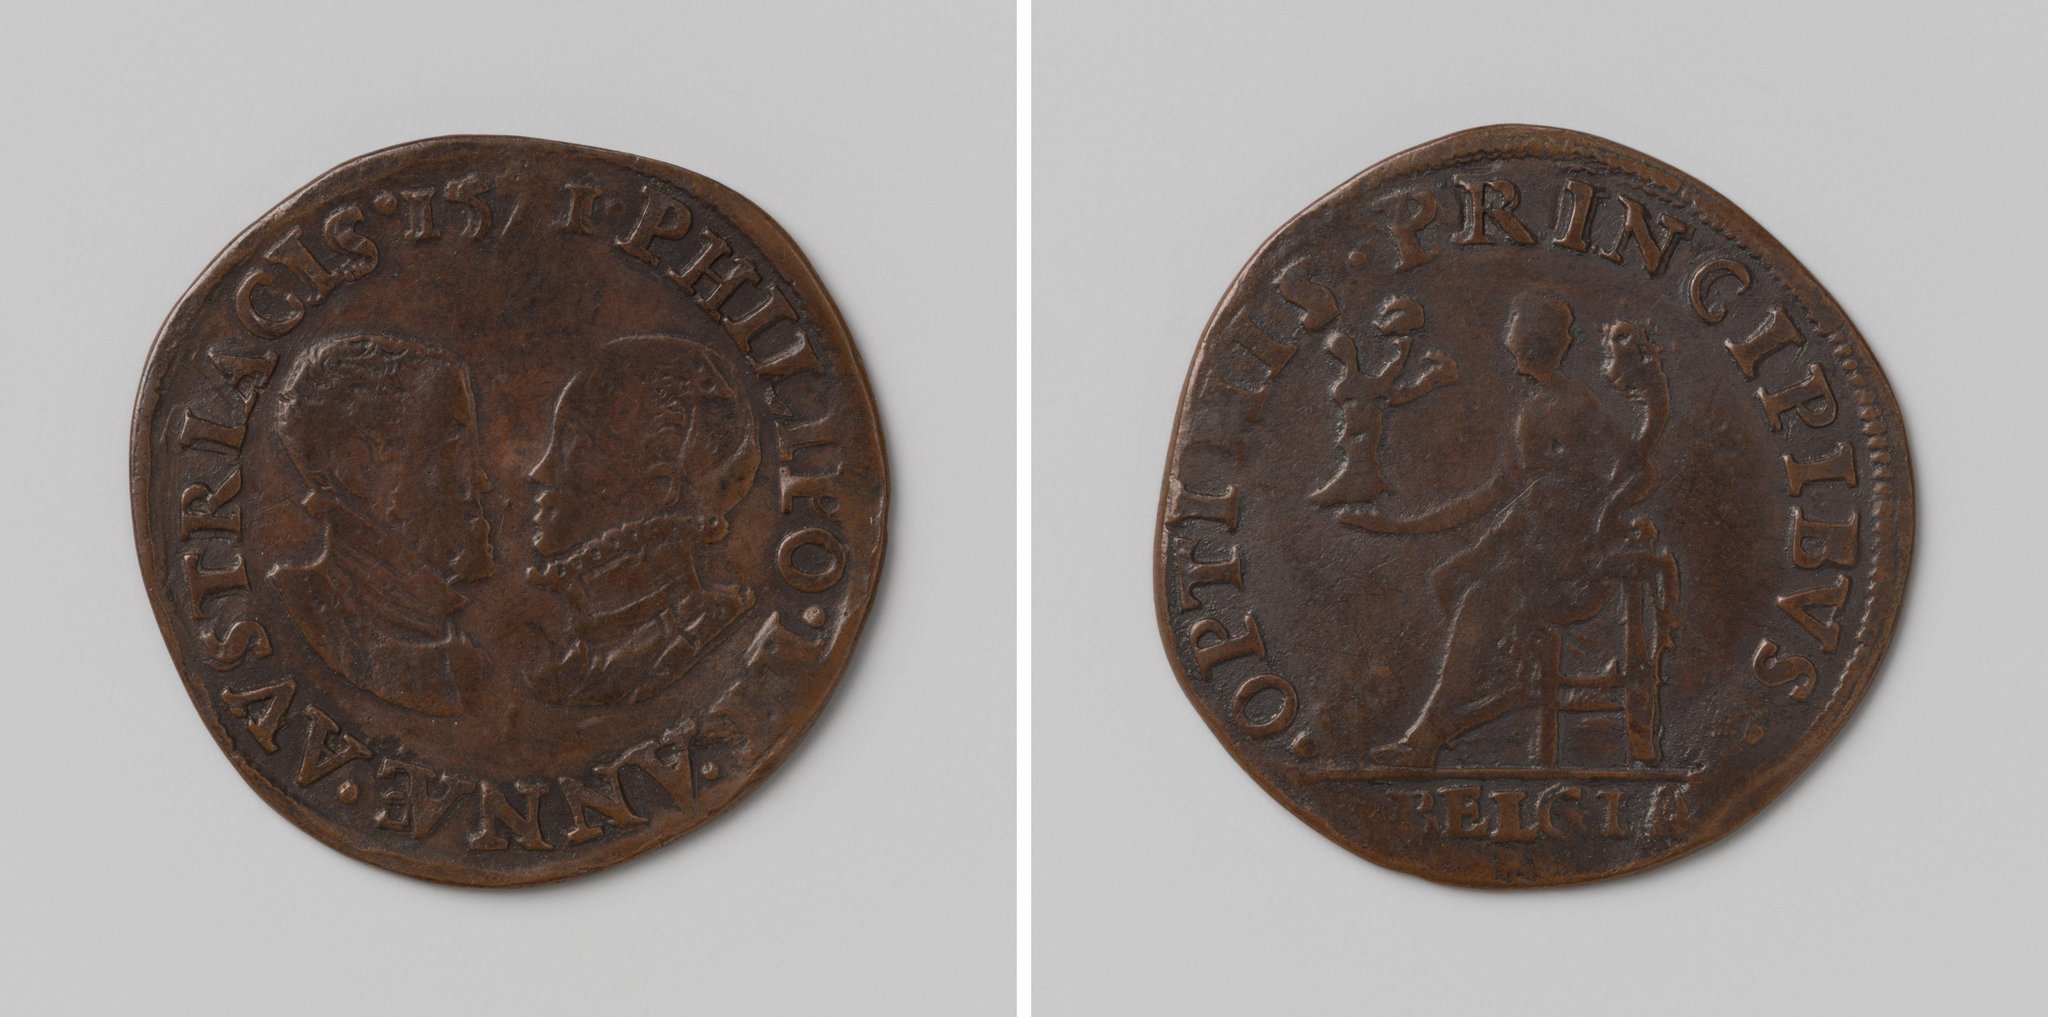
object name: jeton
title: Filips II en Anna-Maria, koning en koningin van Spanje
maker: Anonymous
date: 1571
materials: copper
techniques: striking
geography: low countries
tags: philip ii of spain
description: Koperen penning. Voorzijde: naar elkaar gewende borststukken van man en vrouw binnen omschrift. Keerzijde: zittende vrouw, voorstellende de Nederlanden, houdt gevulde hoorn van overvloed in linker- en Overwinning met lauwerkrans in elk van beide handen in rechterhand binnen omschrift; afsnede: opschrift